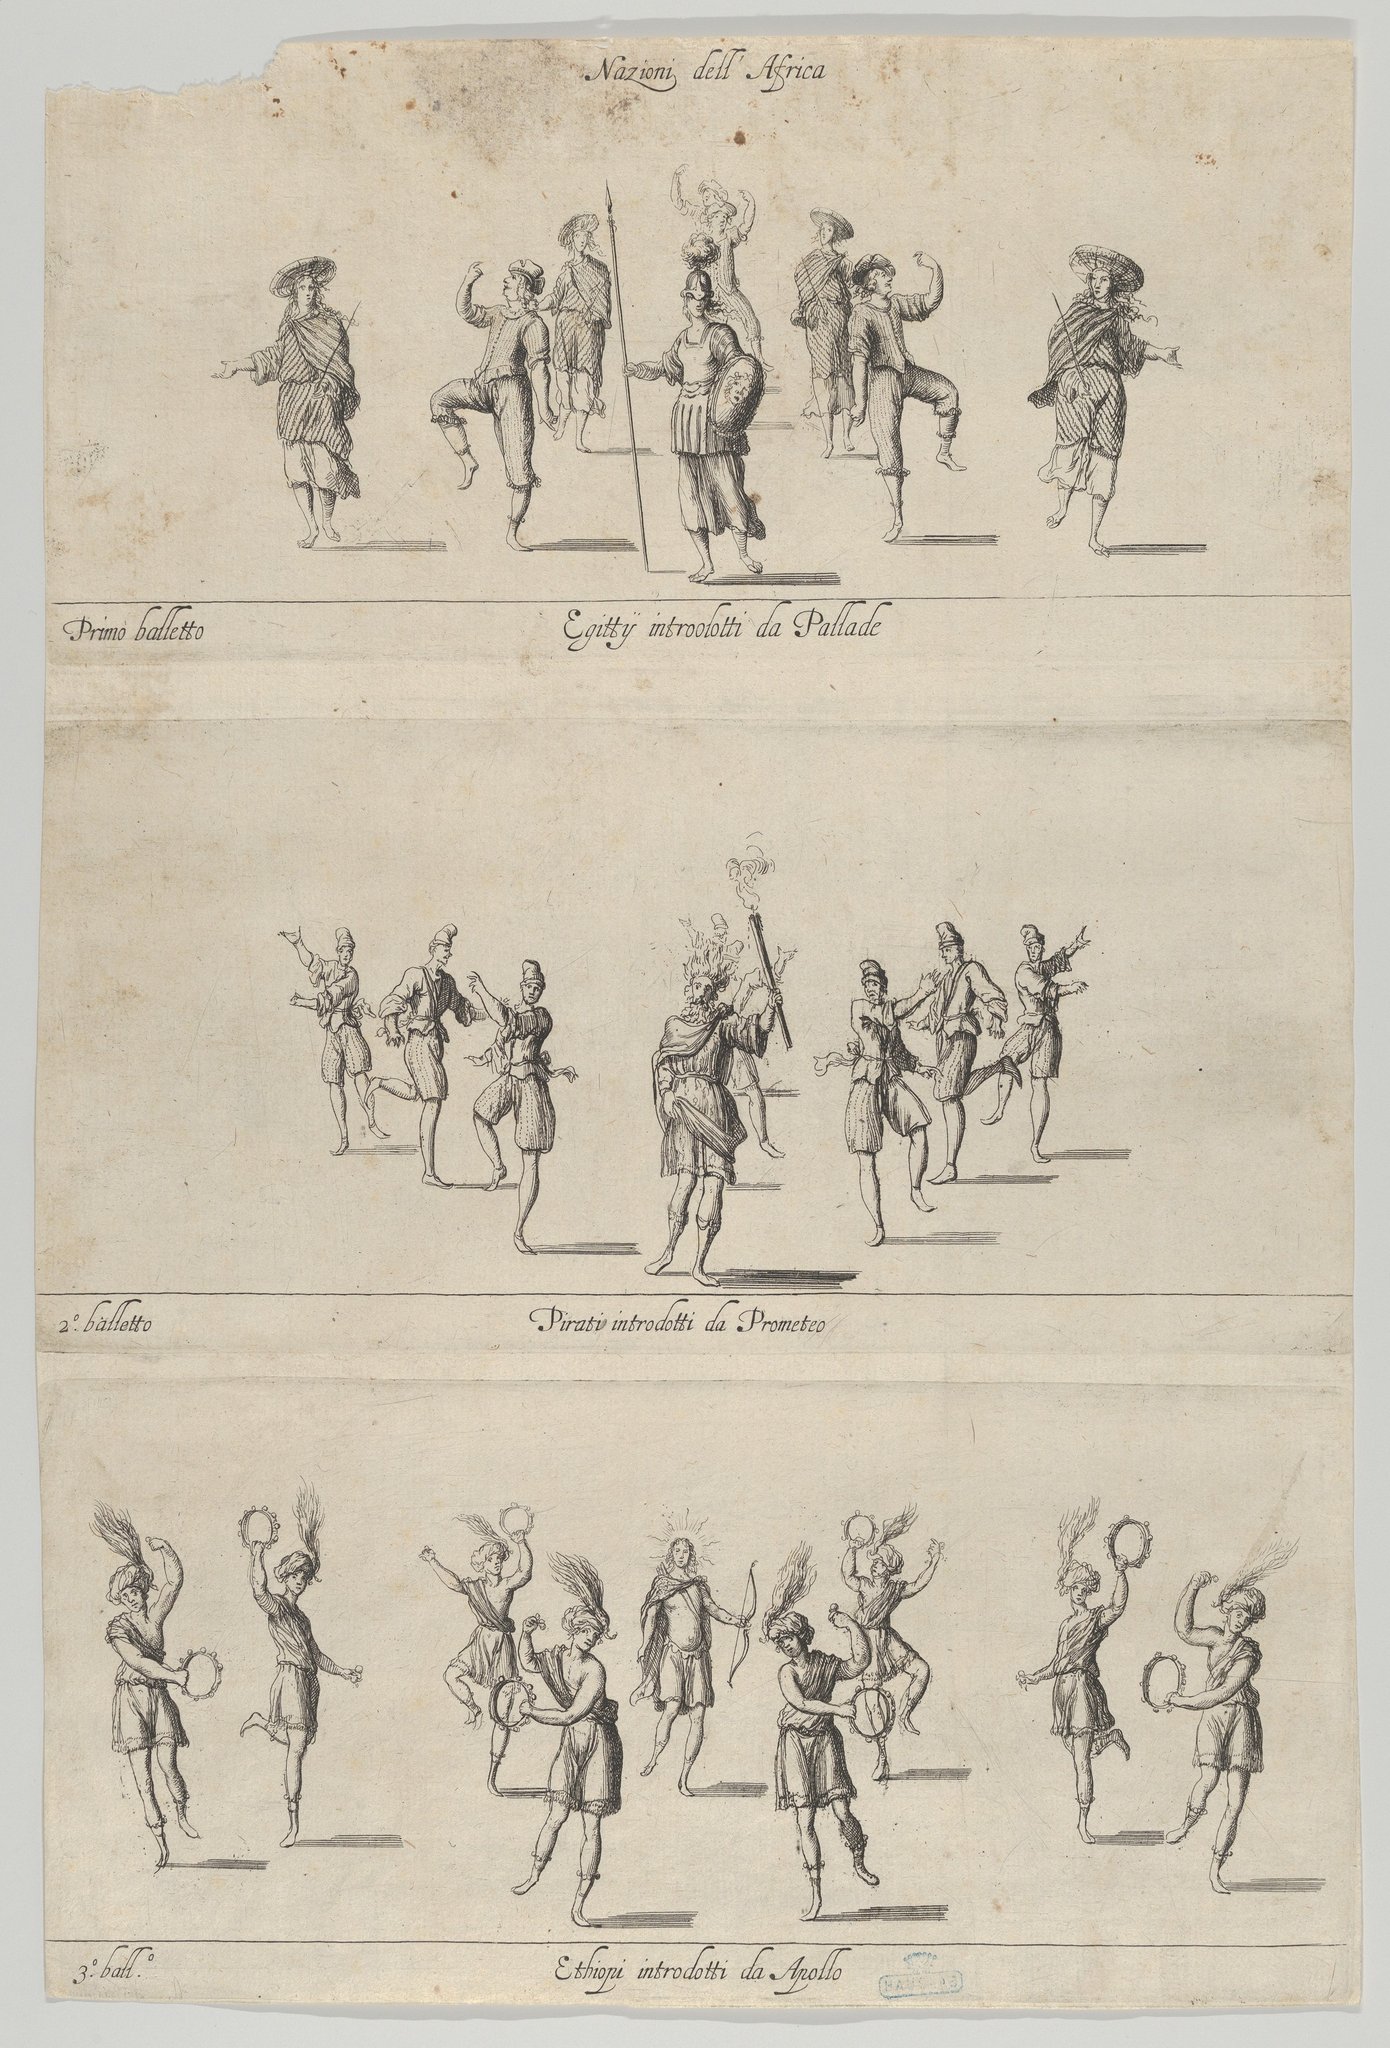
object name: print, fete, ornament architecture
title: Nations of Africa ballets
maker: anonymous, italian, 17th century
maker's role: artist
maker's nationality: italian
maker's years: 1600-1700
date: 1601-1700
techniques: etching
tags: dance,men